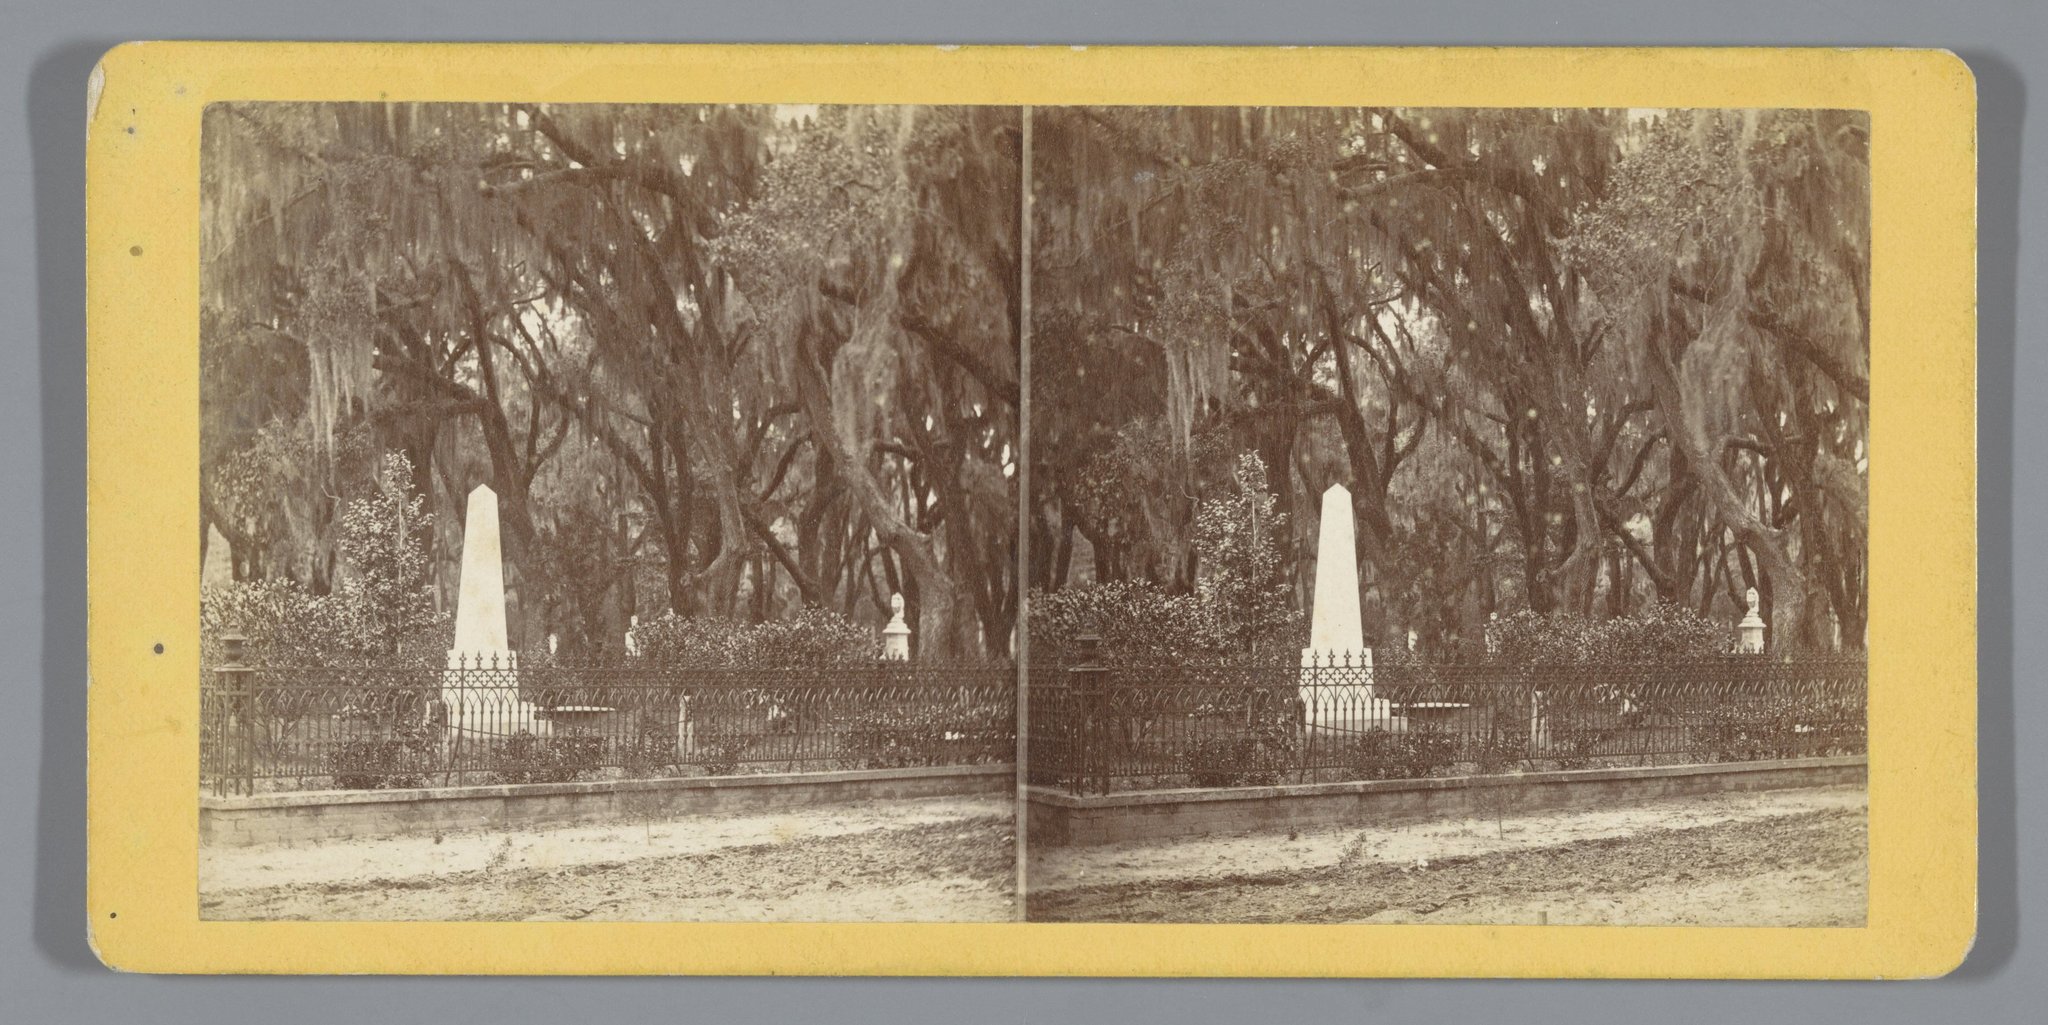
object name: stereograph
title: Bonaventure Cemetery in Savannah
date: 1860-1880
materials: cardboard, paper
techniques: albumen print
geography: savannah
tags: cemetery, park-like burying ground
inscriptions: number: ‘75’, inscription: ‘The beautiful tract of land bearing this name was first settled (...)’